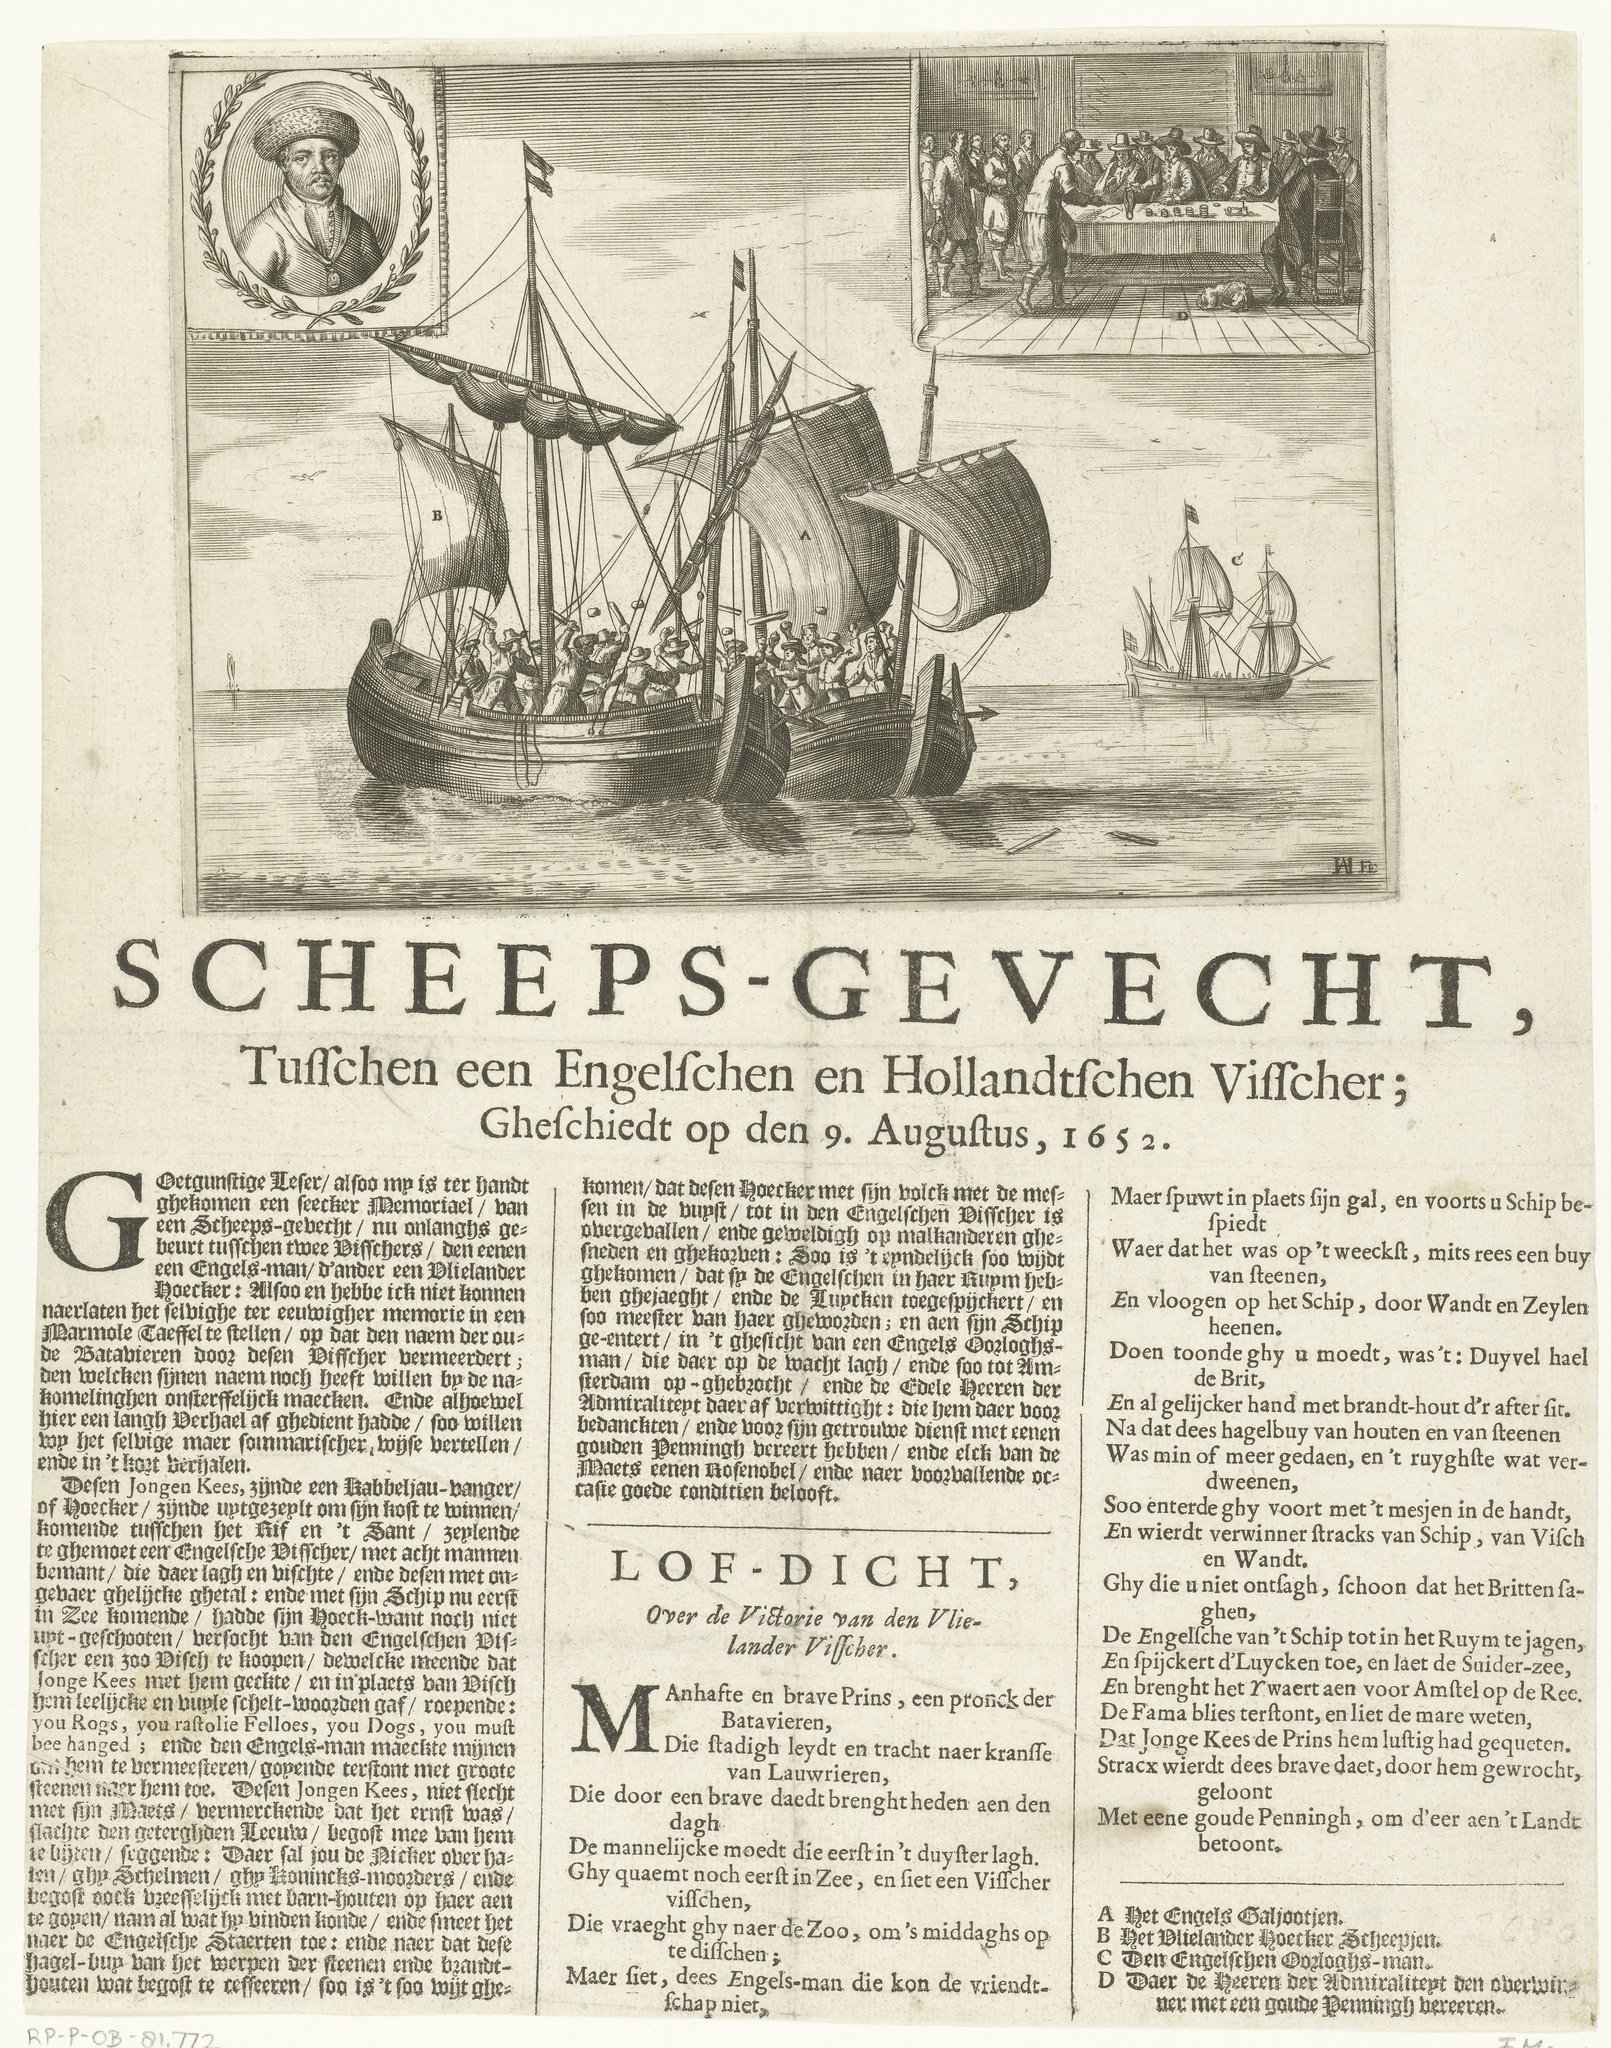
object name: pamphlet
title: Gevecht van Jonge Kees met een Engelse visser, 1652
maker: hugo allard (i)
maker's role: draughtsman, painter, print maker, publisher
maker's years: 1620-1684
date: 1652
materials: paper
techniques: engraving, letterpress printing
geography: northern netherlands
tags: battle (+ naval force)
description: Pamflet over een gevecht tussen een Hollandse visser van Vlieland genaamd Jonge Kees en een Engelse visser op 9 augustus 1652. Het gevecht tussen de bemanningen van de twee vissersschepen, linksboven een portret van Jonge Kees, rechts zijn beloning door de Admiraliteit. Onder de plaat gedrukt tekst in 3 kolommen met een Lof-dicht, over de Victorie van den Vlielander Visscher.